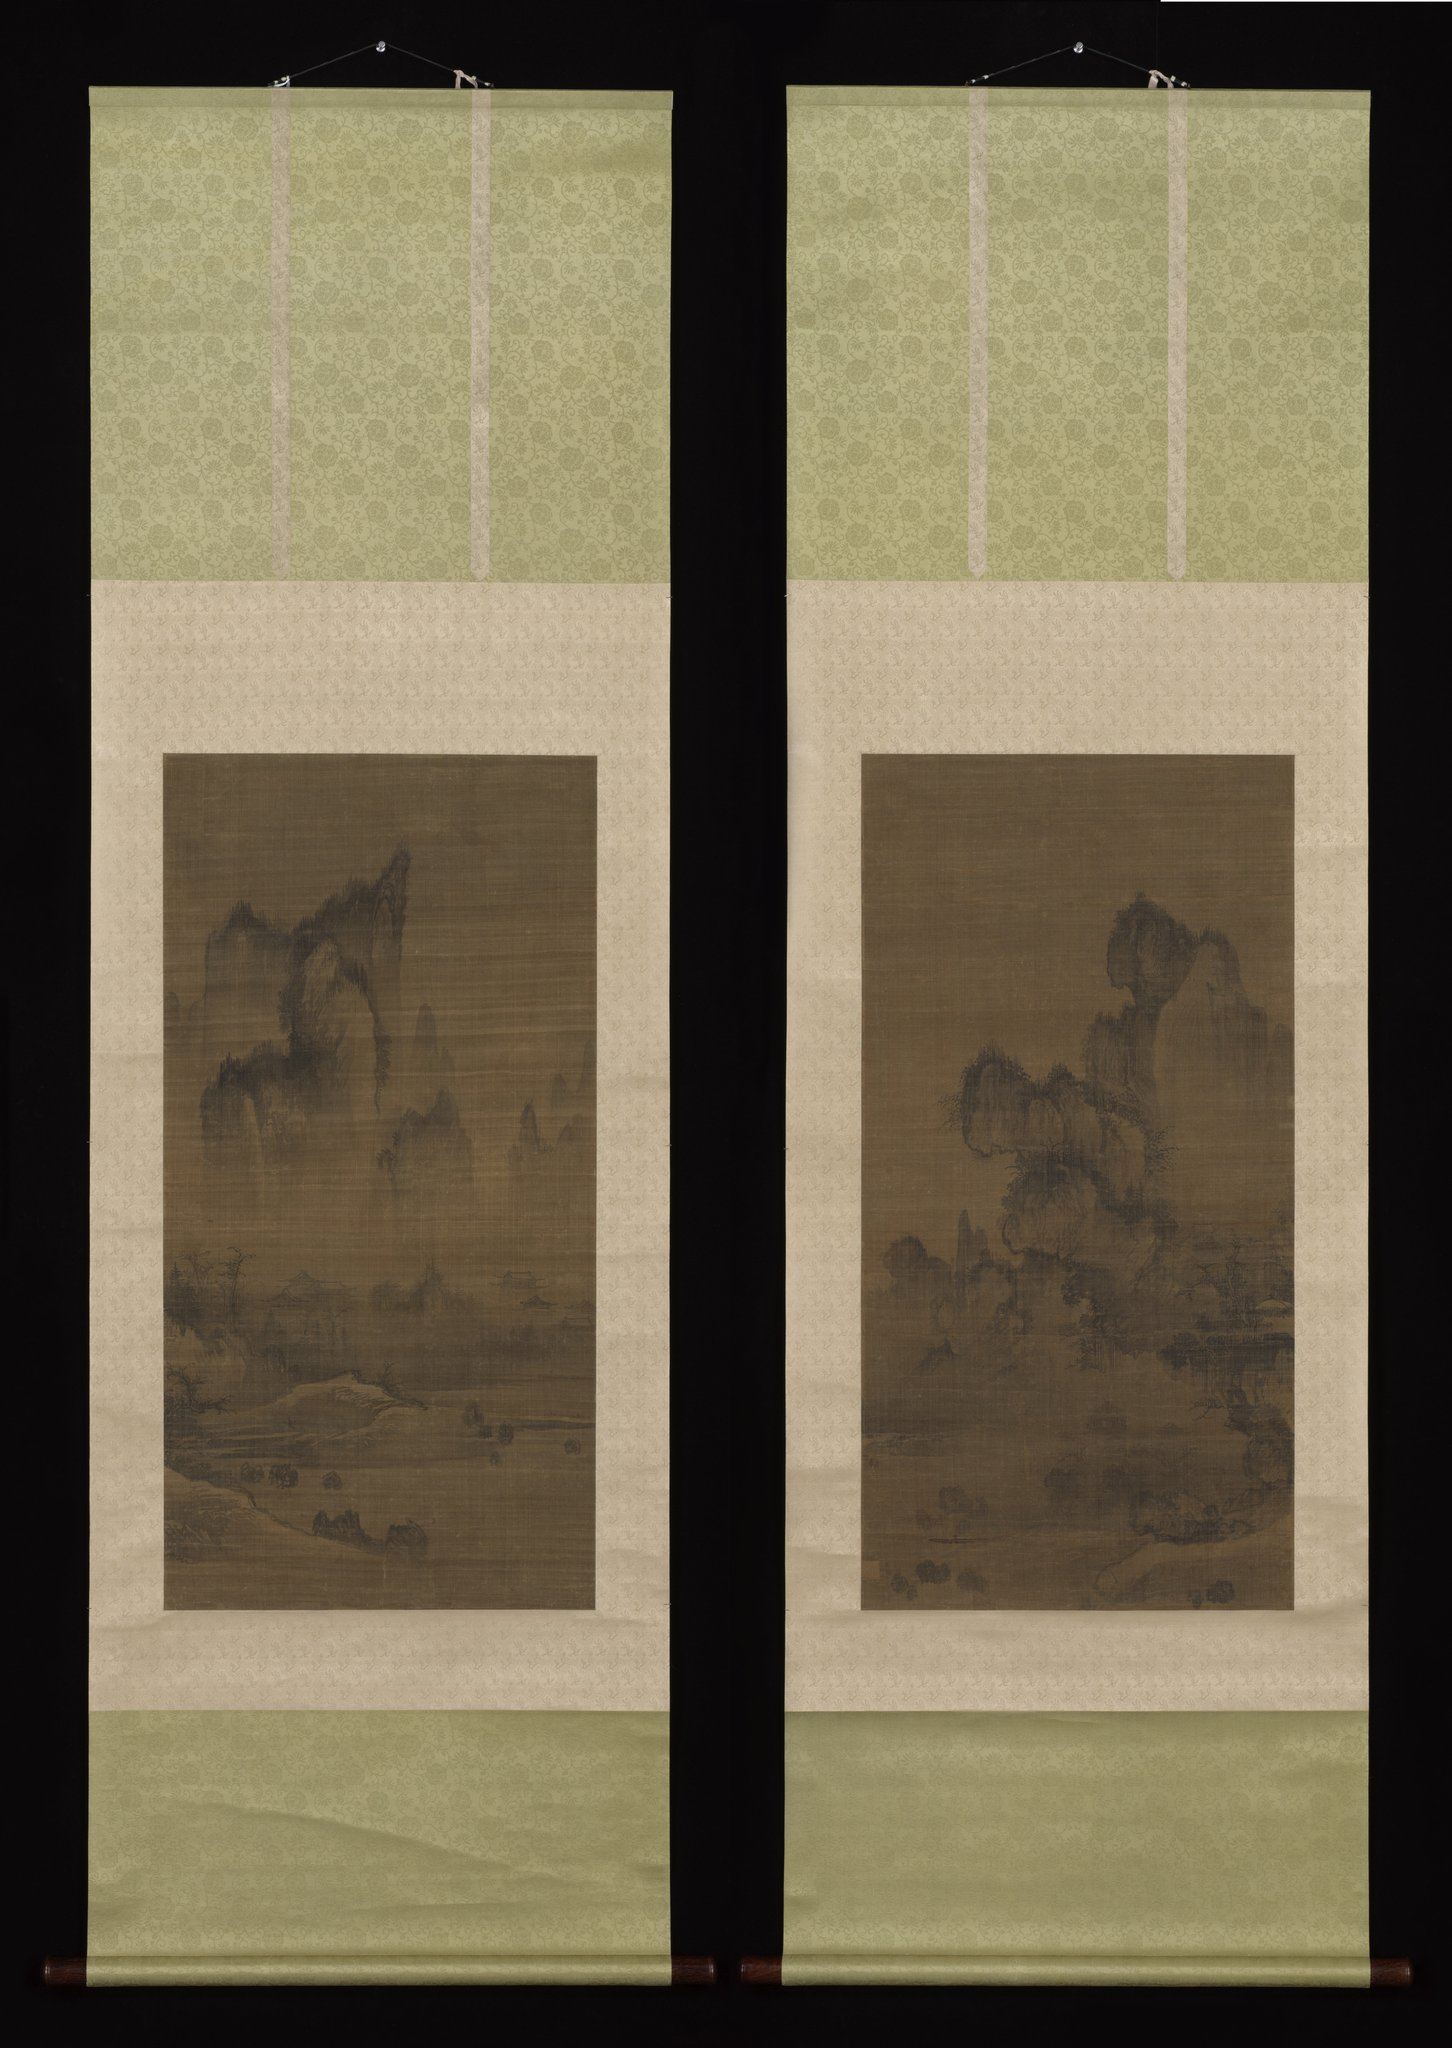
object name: hanging scroll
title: Evening bell from mist-shrouded temple (left); Autumn moon over Lake Dongting (right)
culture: korean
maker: an gyeon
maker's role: artist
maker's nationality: korean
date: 1450-1500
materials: ink, silk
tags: mountains,landscapes